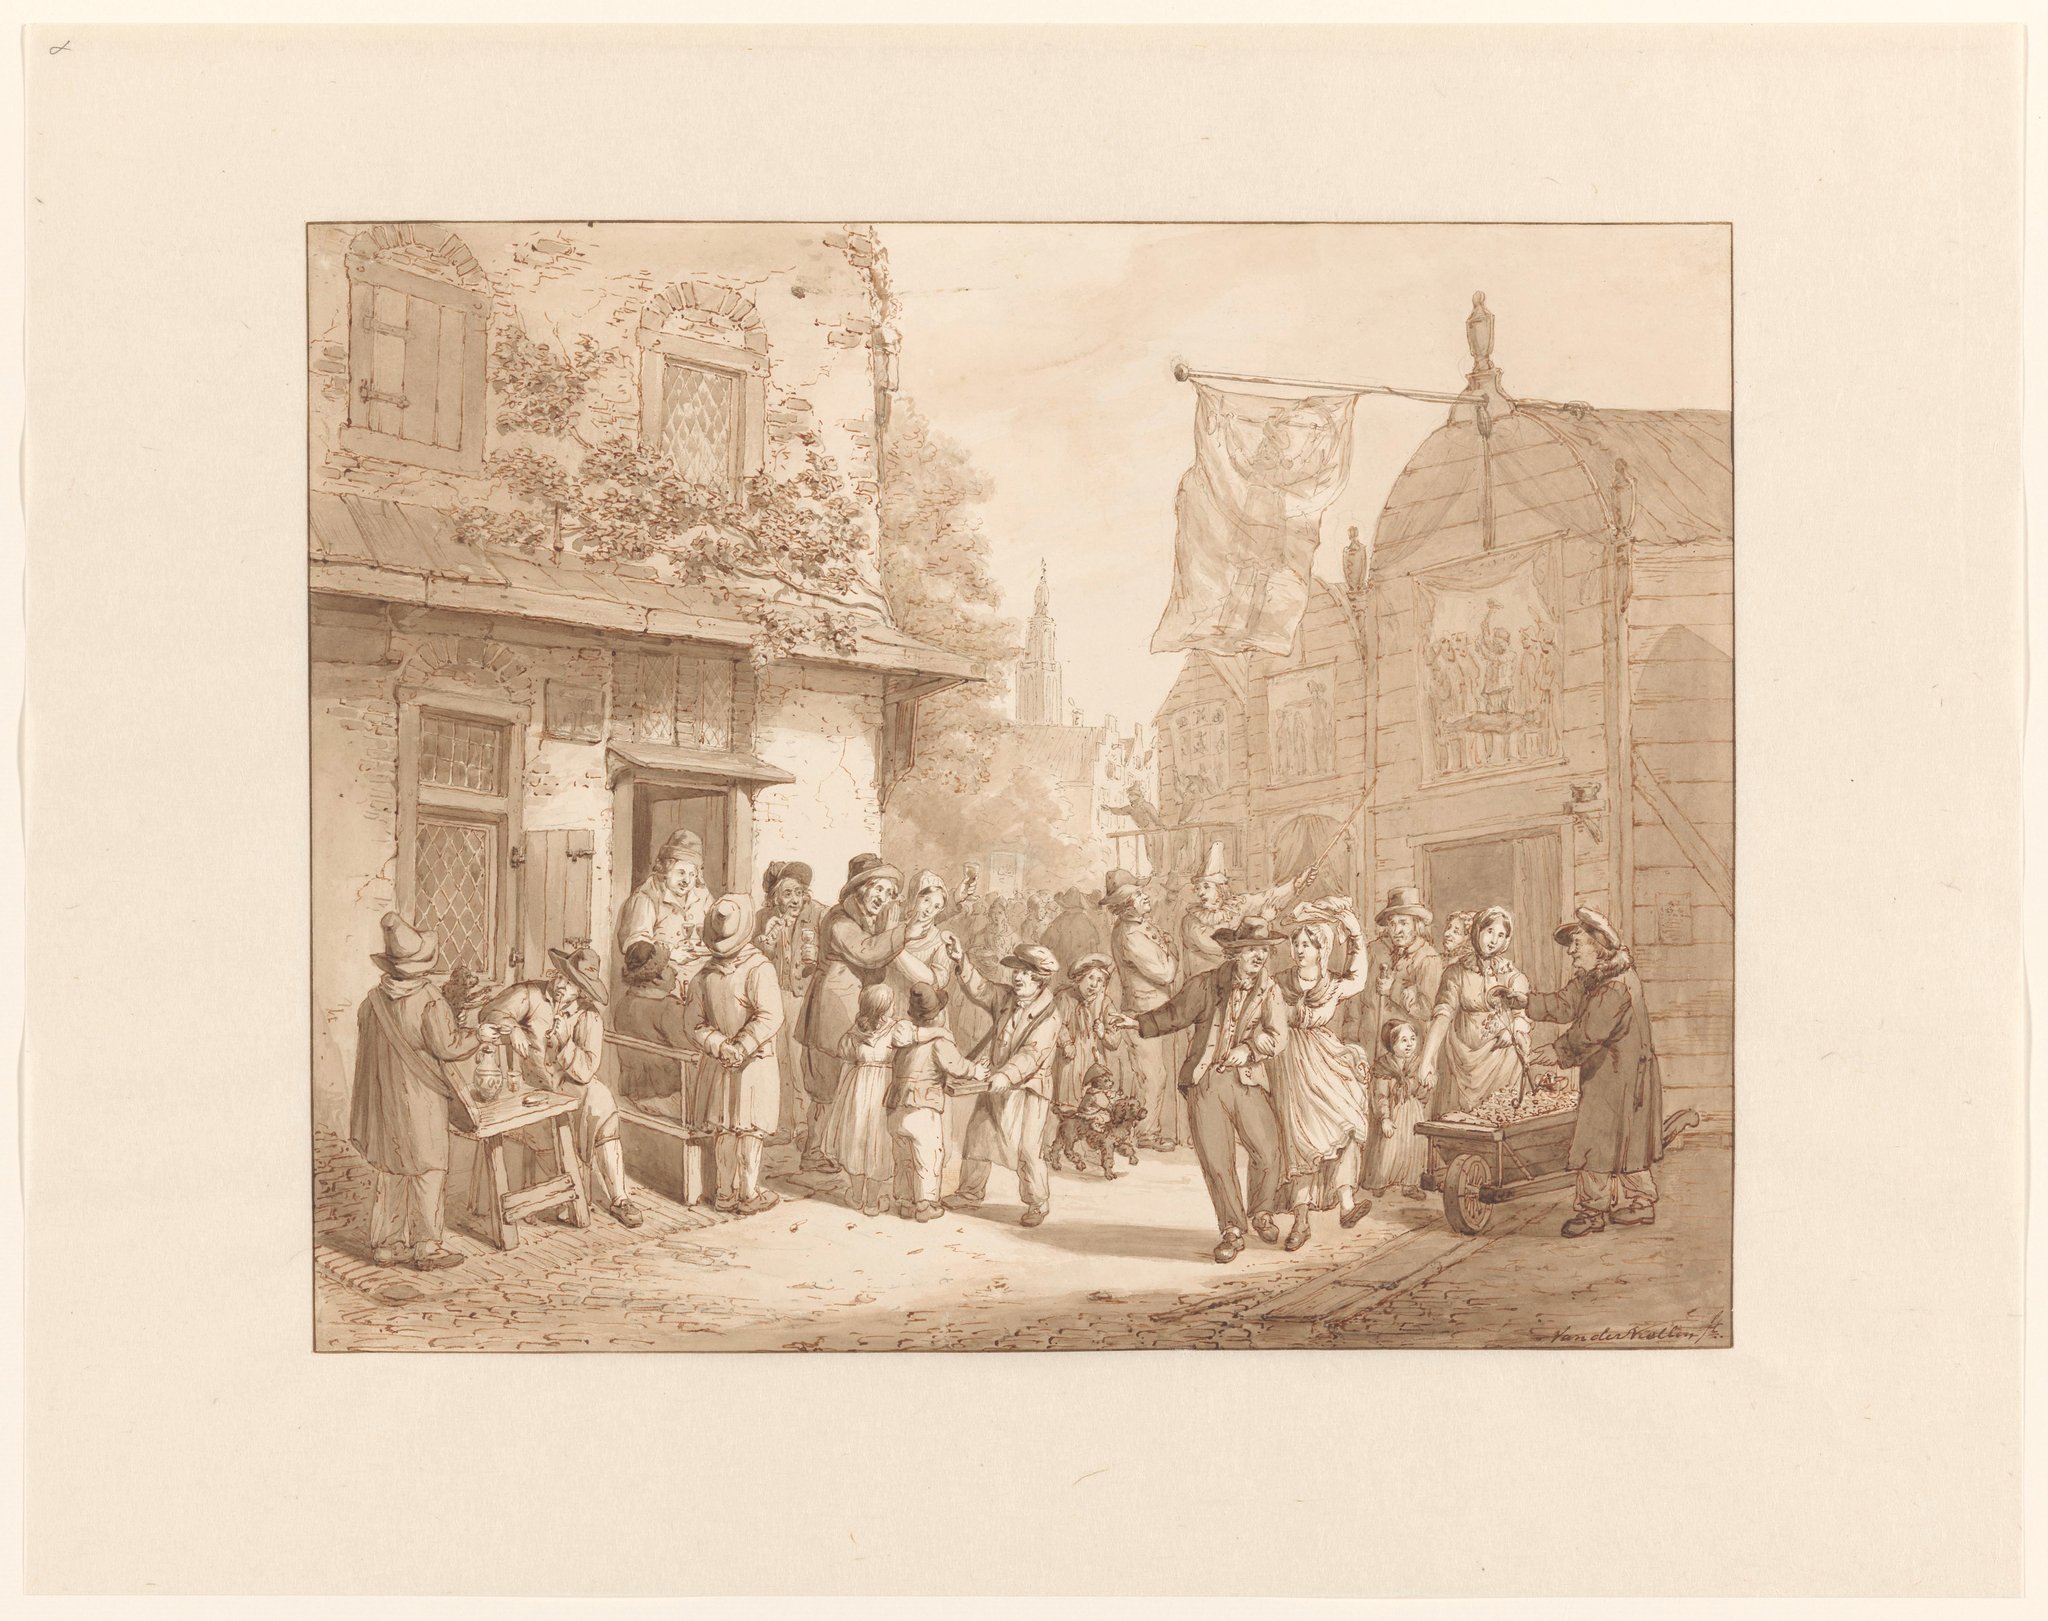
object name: drawing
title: Kermis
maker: david van der kellen (1804-1879)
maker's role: die cutter, draughtsman, print maker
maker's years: 1804-1879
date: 1840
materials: ink, paper, pencil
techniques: brush, pen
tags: (annual) fair, trade fair